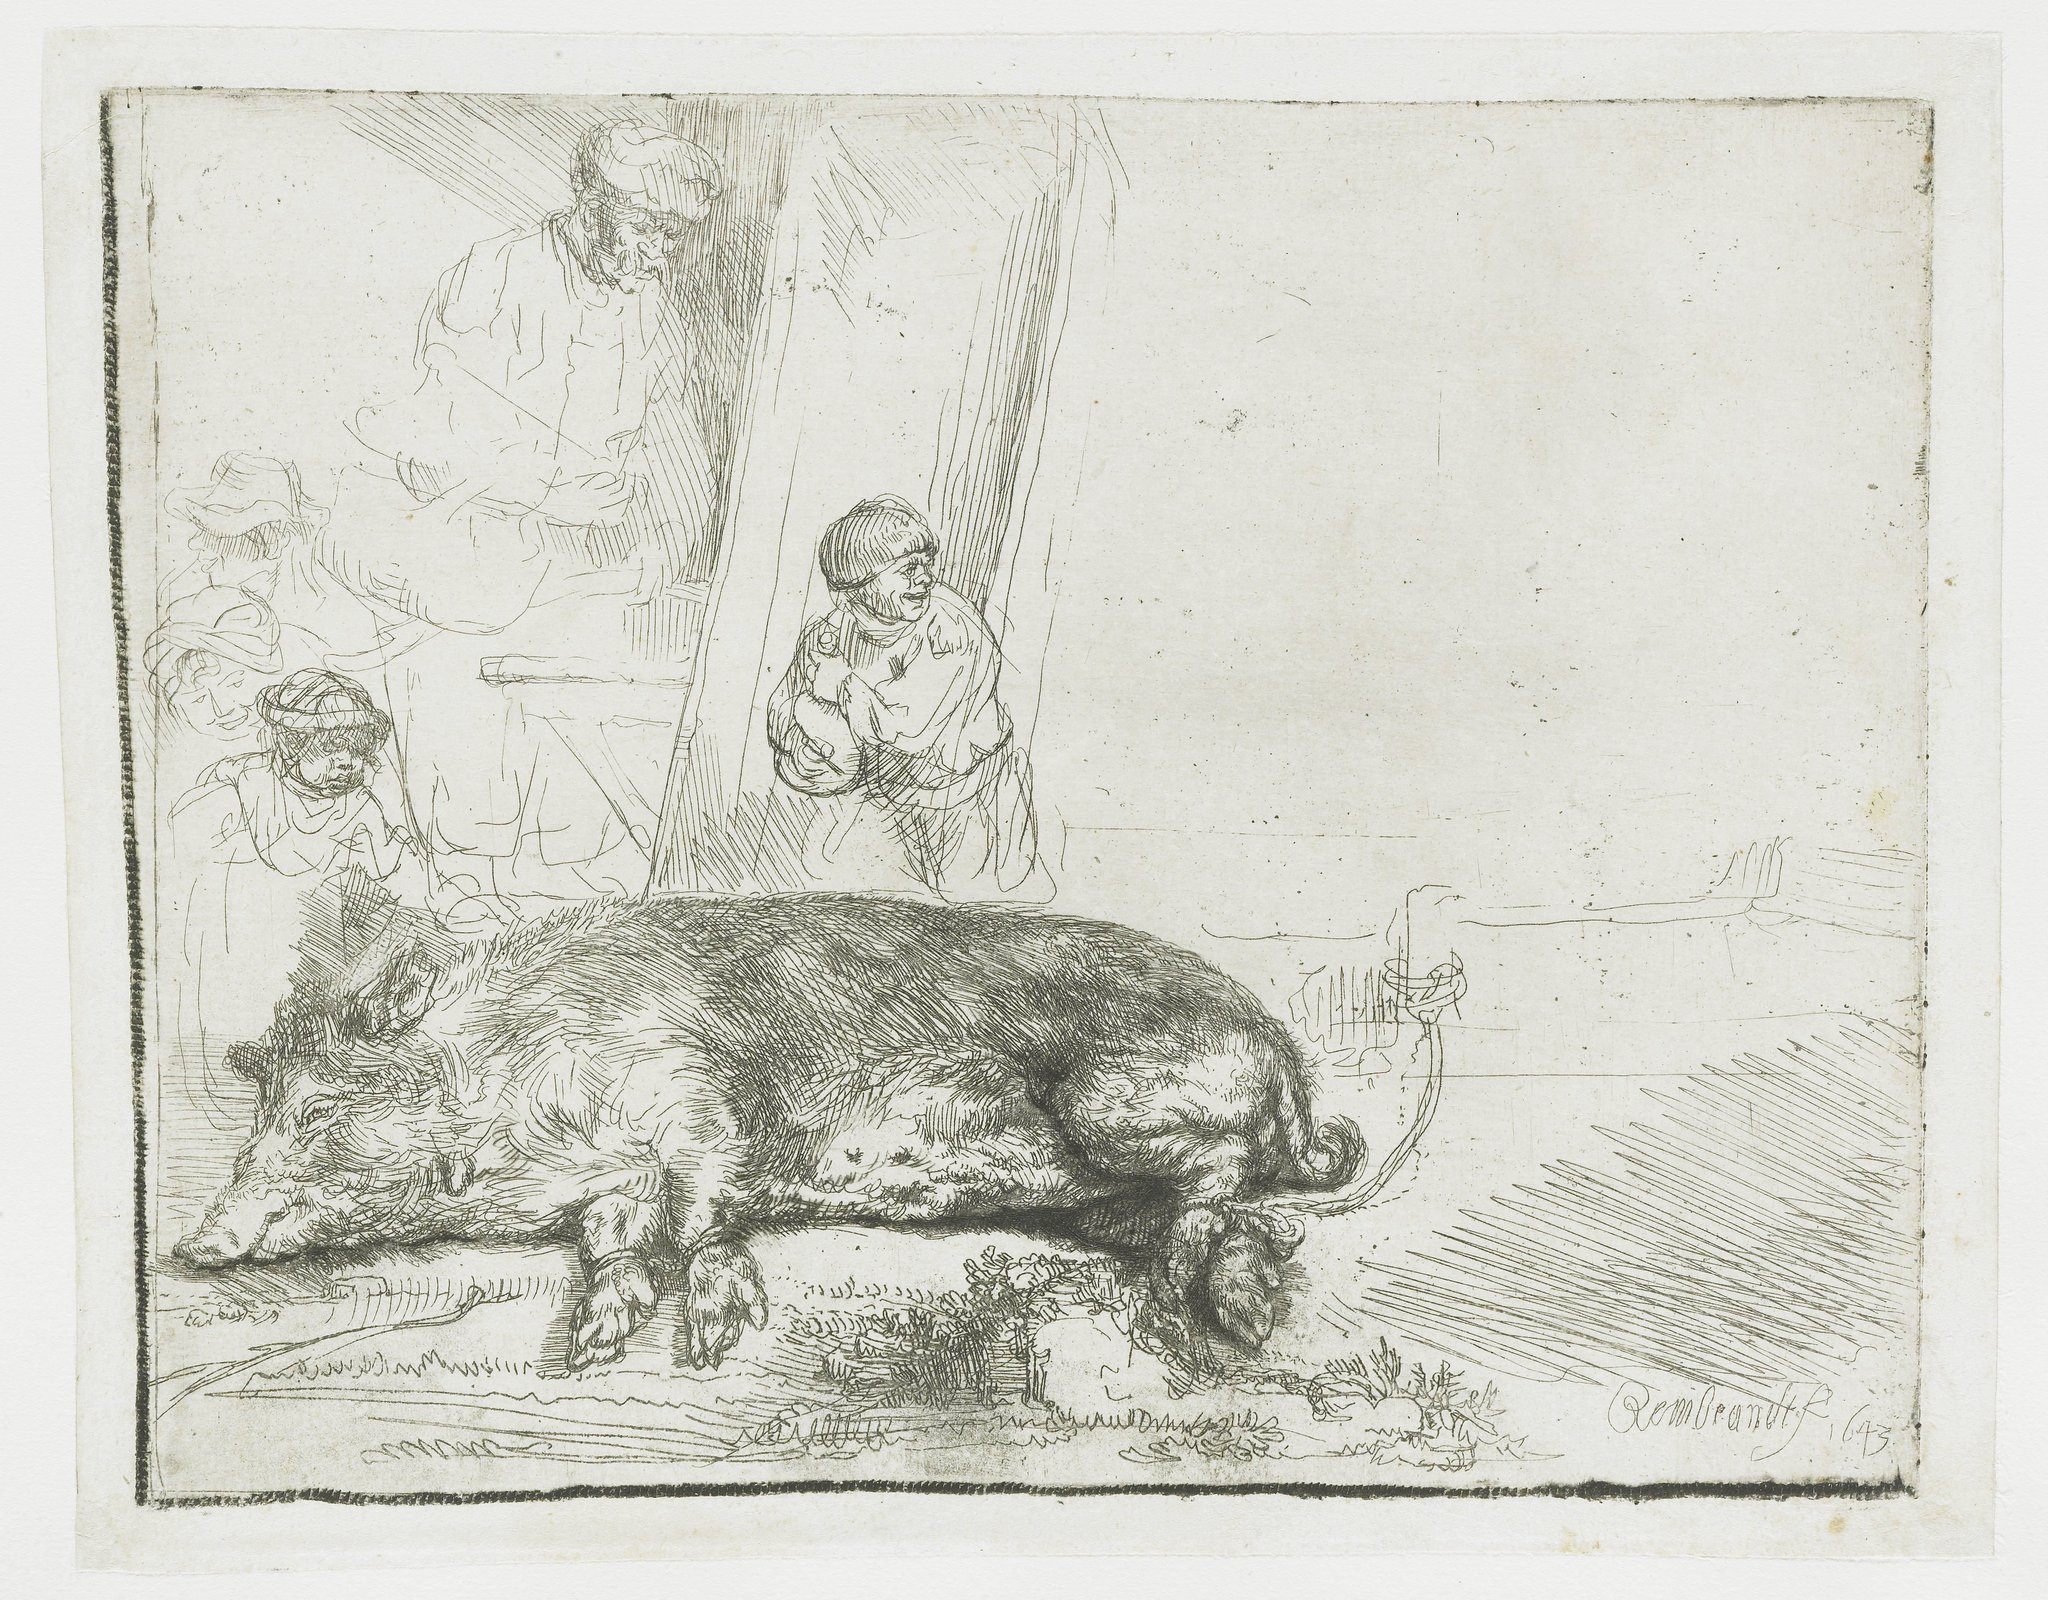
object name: print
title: The hog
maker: rembrandt van rijn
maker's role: draughtsman, painter, print maker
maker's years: 1606-1669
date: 1643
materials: paper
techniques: drypoint, etching, intaglio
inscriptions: signature and date: ‘Rembrandt f 1643’, collector's mark: Lugt 240